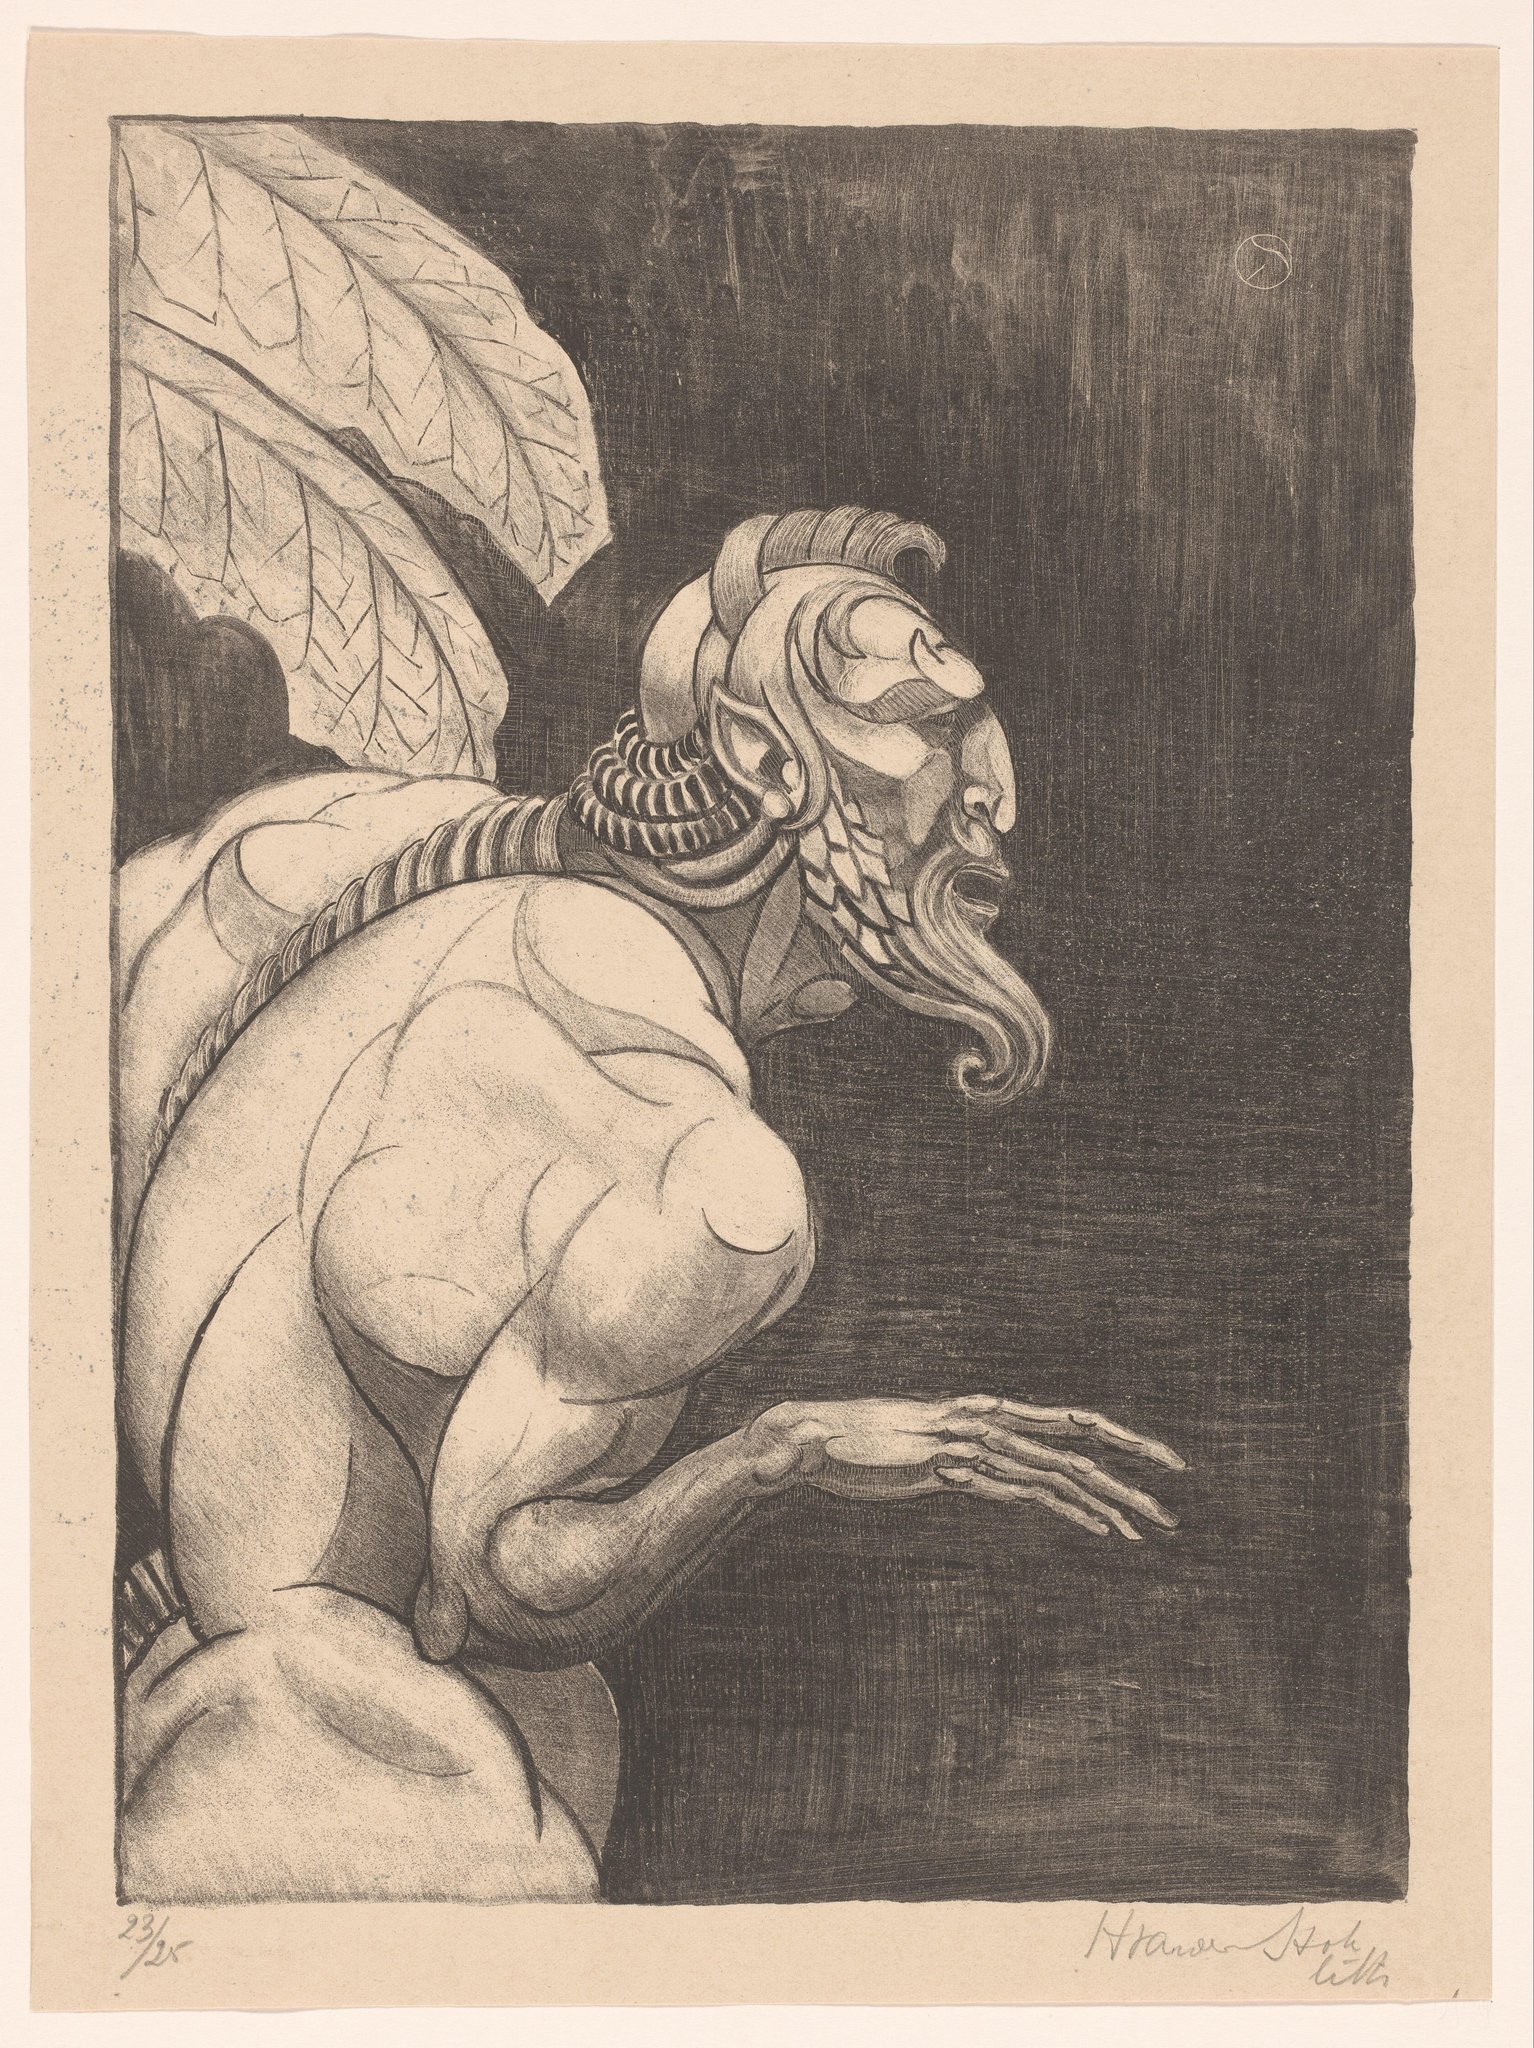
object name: print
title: Centaur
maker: henri van der stok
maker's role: print maker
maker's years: 1870-1946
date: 1880-1932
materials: paper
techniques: lithograph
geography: netherlands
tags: centaurs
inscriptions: collector's mark: Lugt 2228